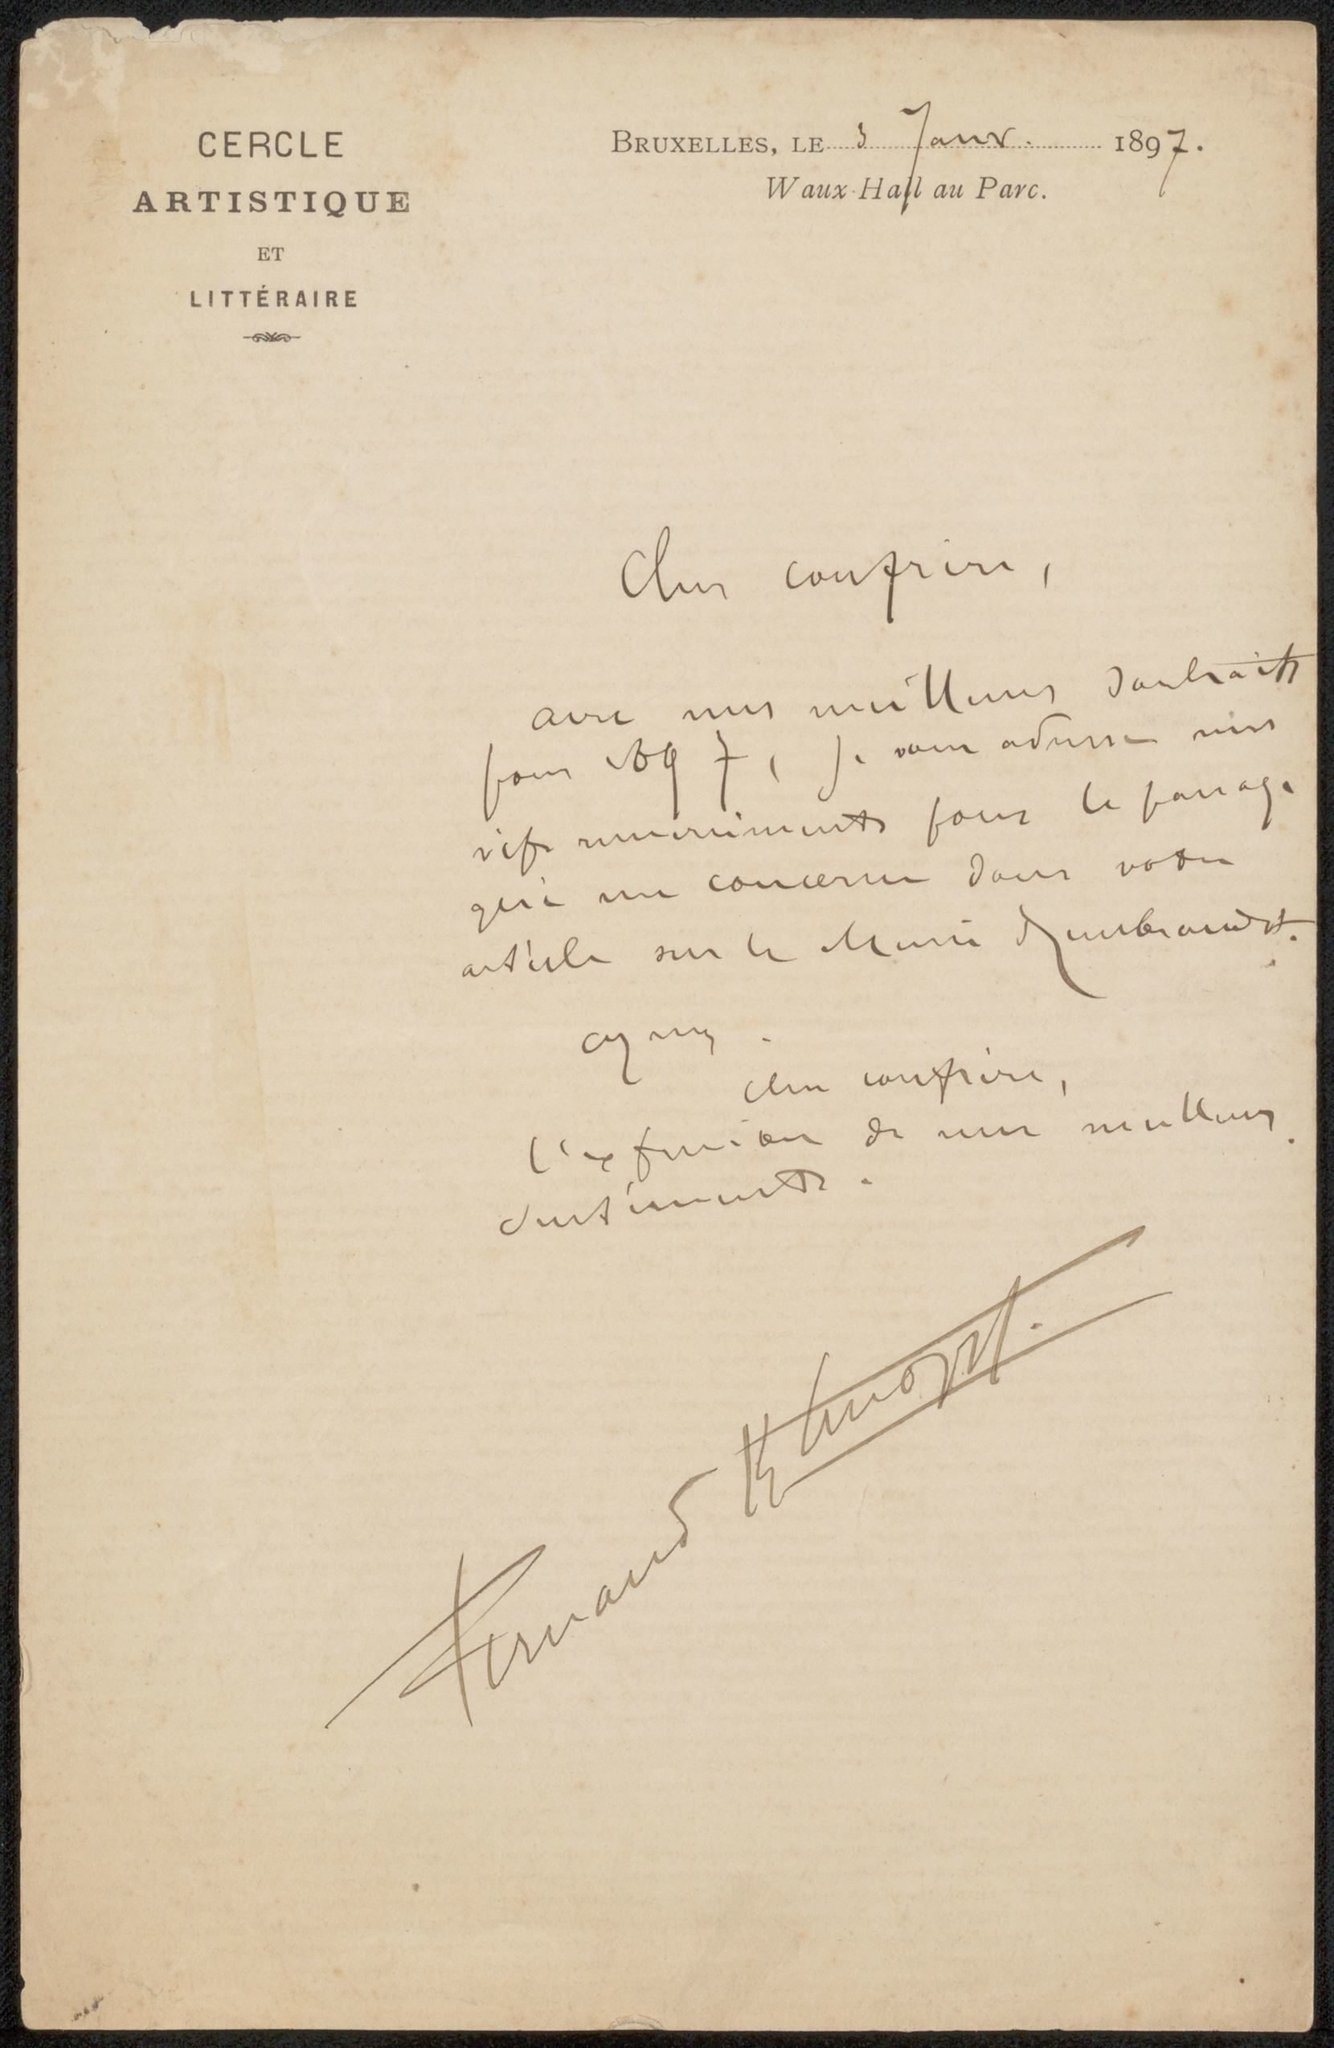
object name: letter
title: Brief aan Philip Zilcken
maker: fernand khnopff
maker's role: draughtsman, print maker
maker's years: 1858-1921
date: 1897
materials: ink, paper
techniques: pen, printing, writing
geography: brussels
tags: amsterdam, rembrandt van rijn, the hague, painter, philip zilcken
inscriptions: collector's mark: ‘RPK’